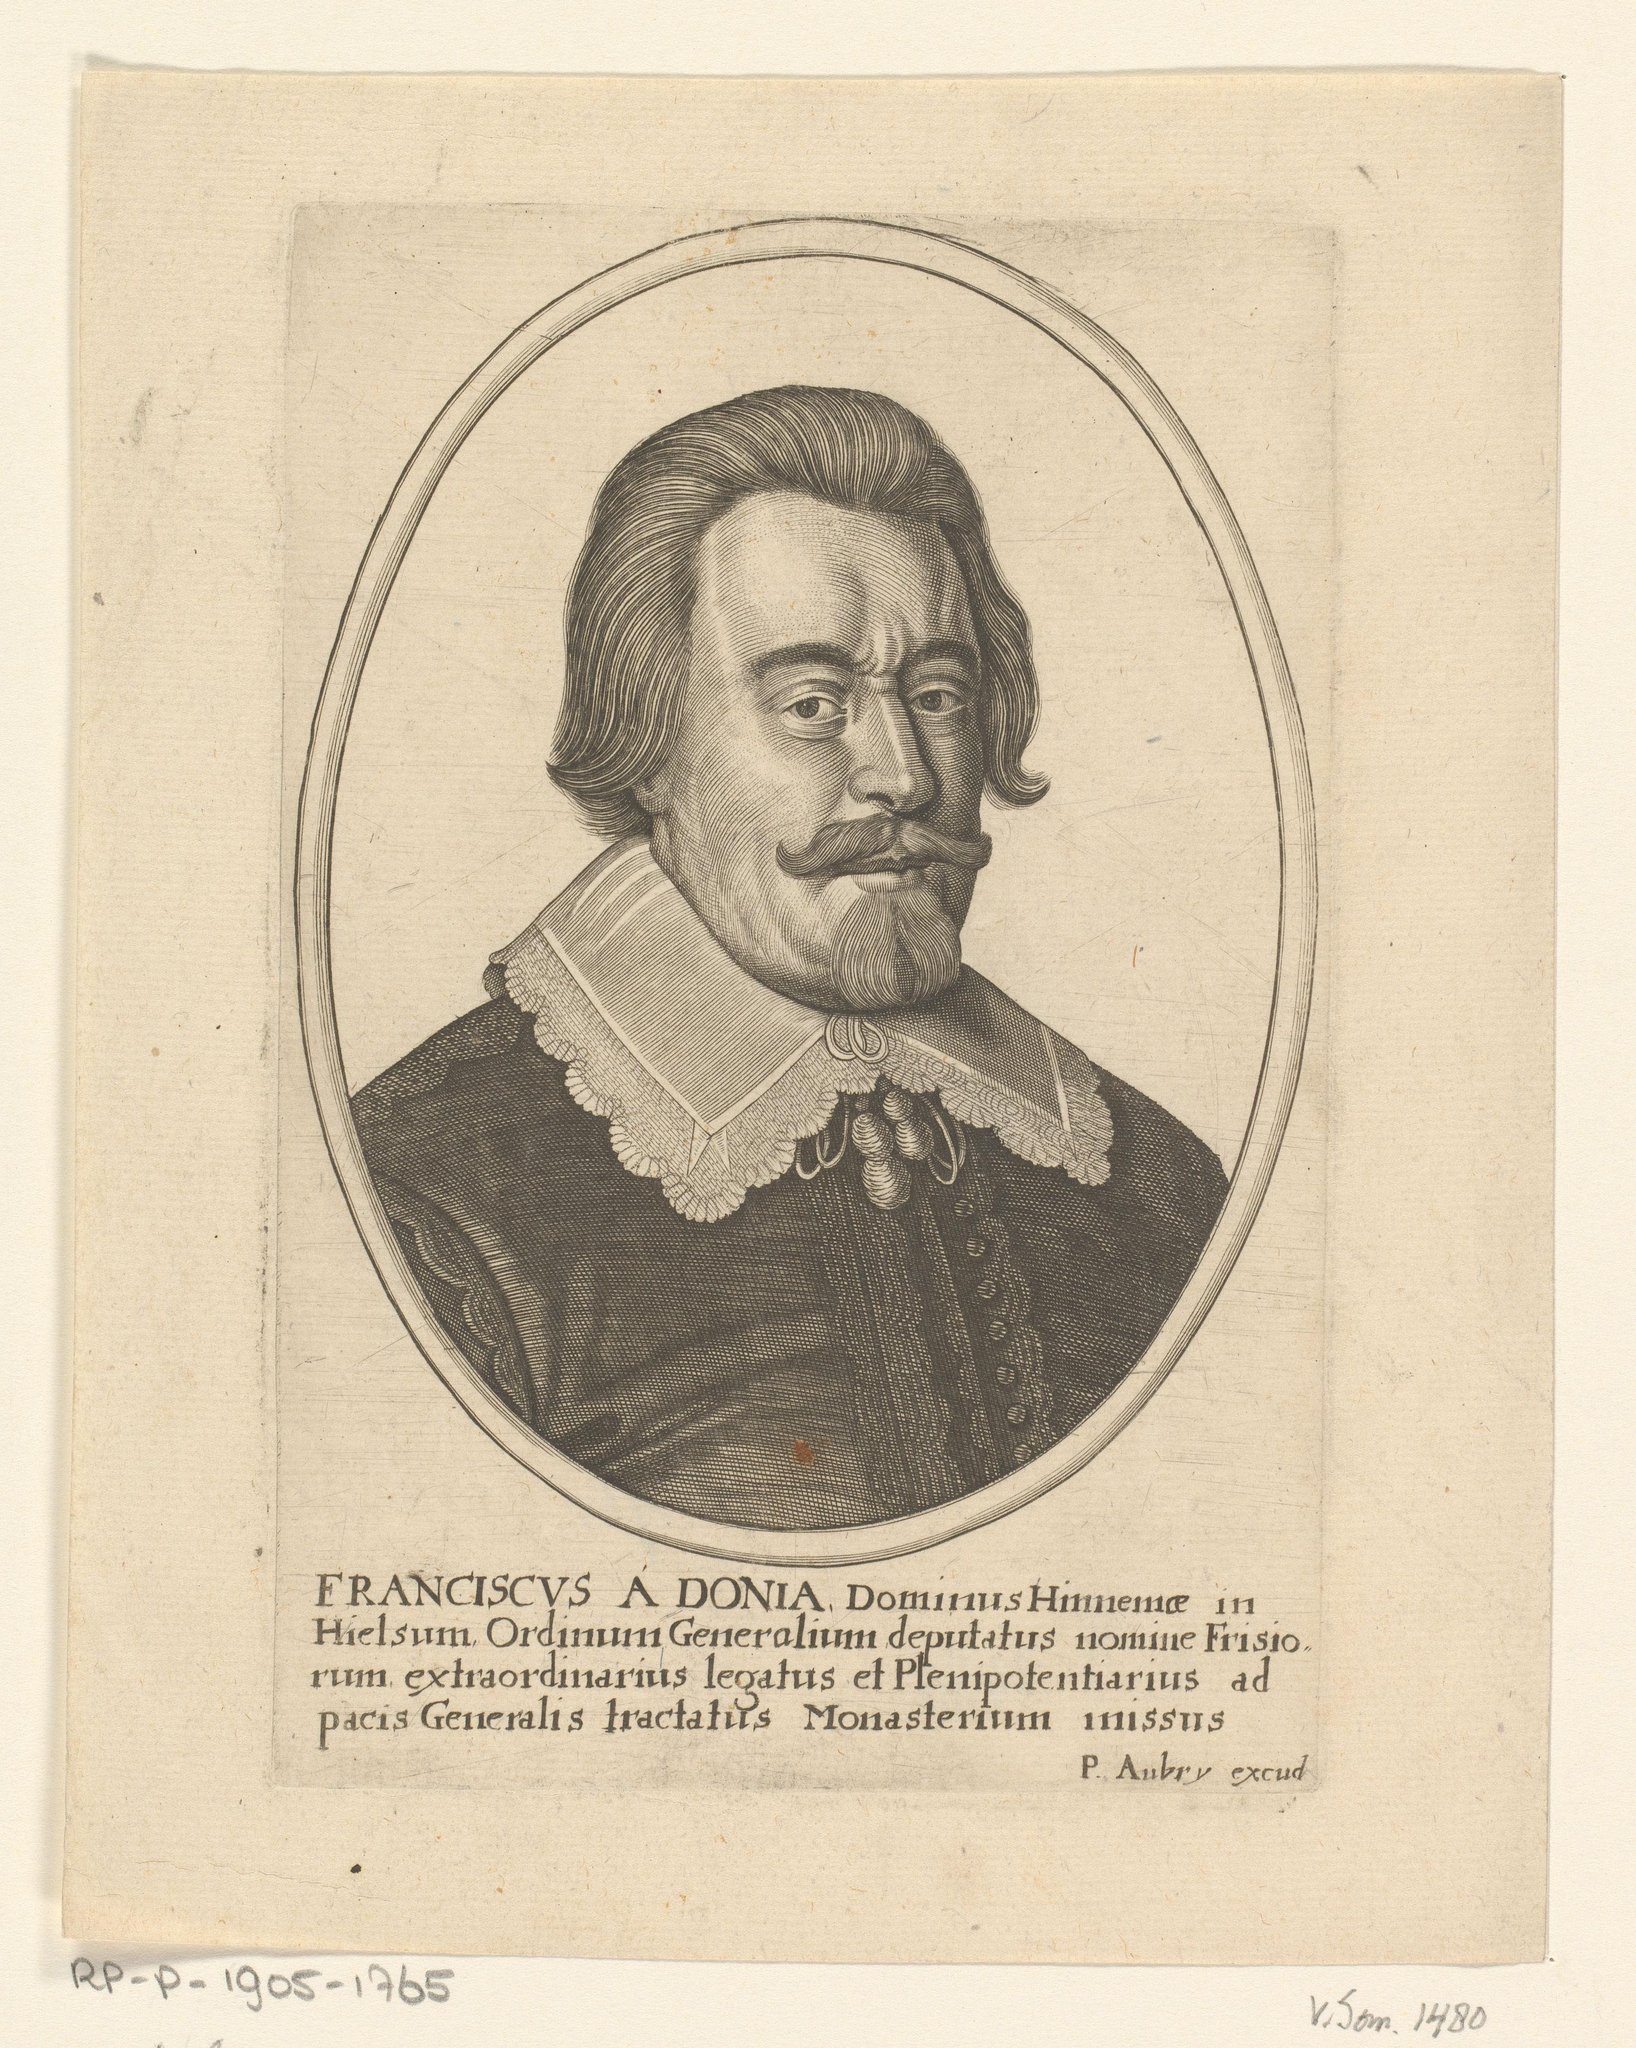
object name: print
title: Portretten van afgevaardigden bij de Vrede van Westfalen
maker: Anonymous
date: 1648-1650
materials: paper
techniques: engraving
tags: historical persons, politician, e.g. party leader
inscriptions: collector's mark: Lugt 2228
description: Met vierregelig onderschrift in het Latijn.